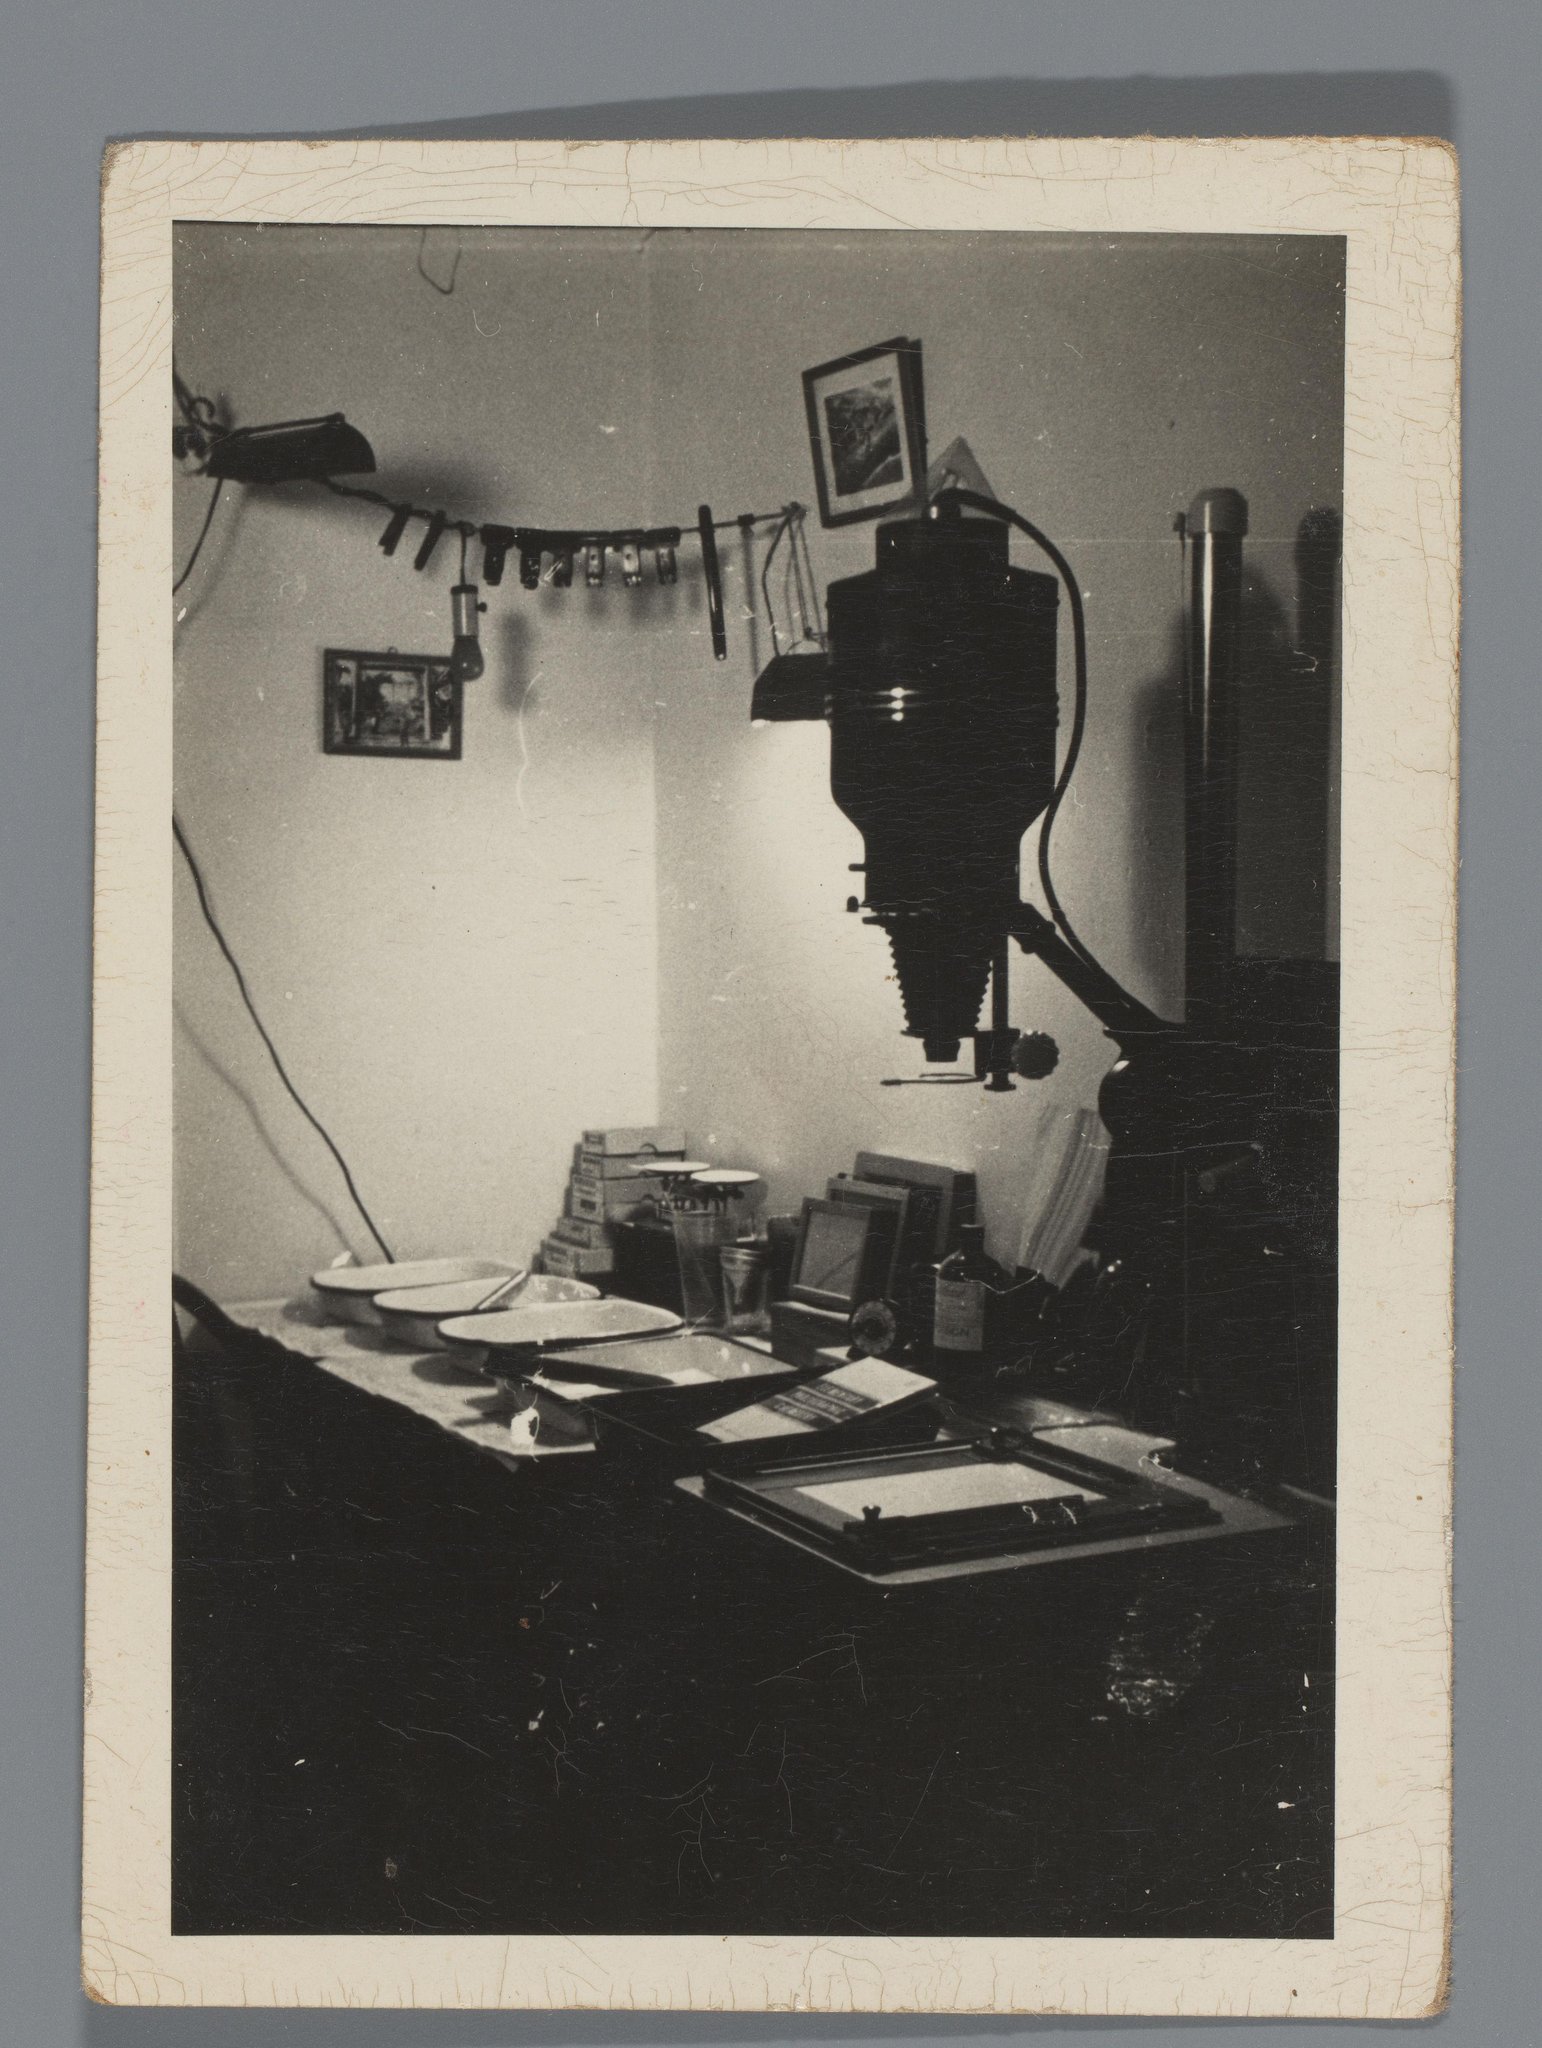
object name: photograph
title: Donkere kamer met vergroter en werktafel met bakken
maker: Anonymous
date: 1940-1960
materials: photographic support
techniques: gelatin silver print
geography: united states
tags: united states of america